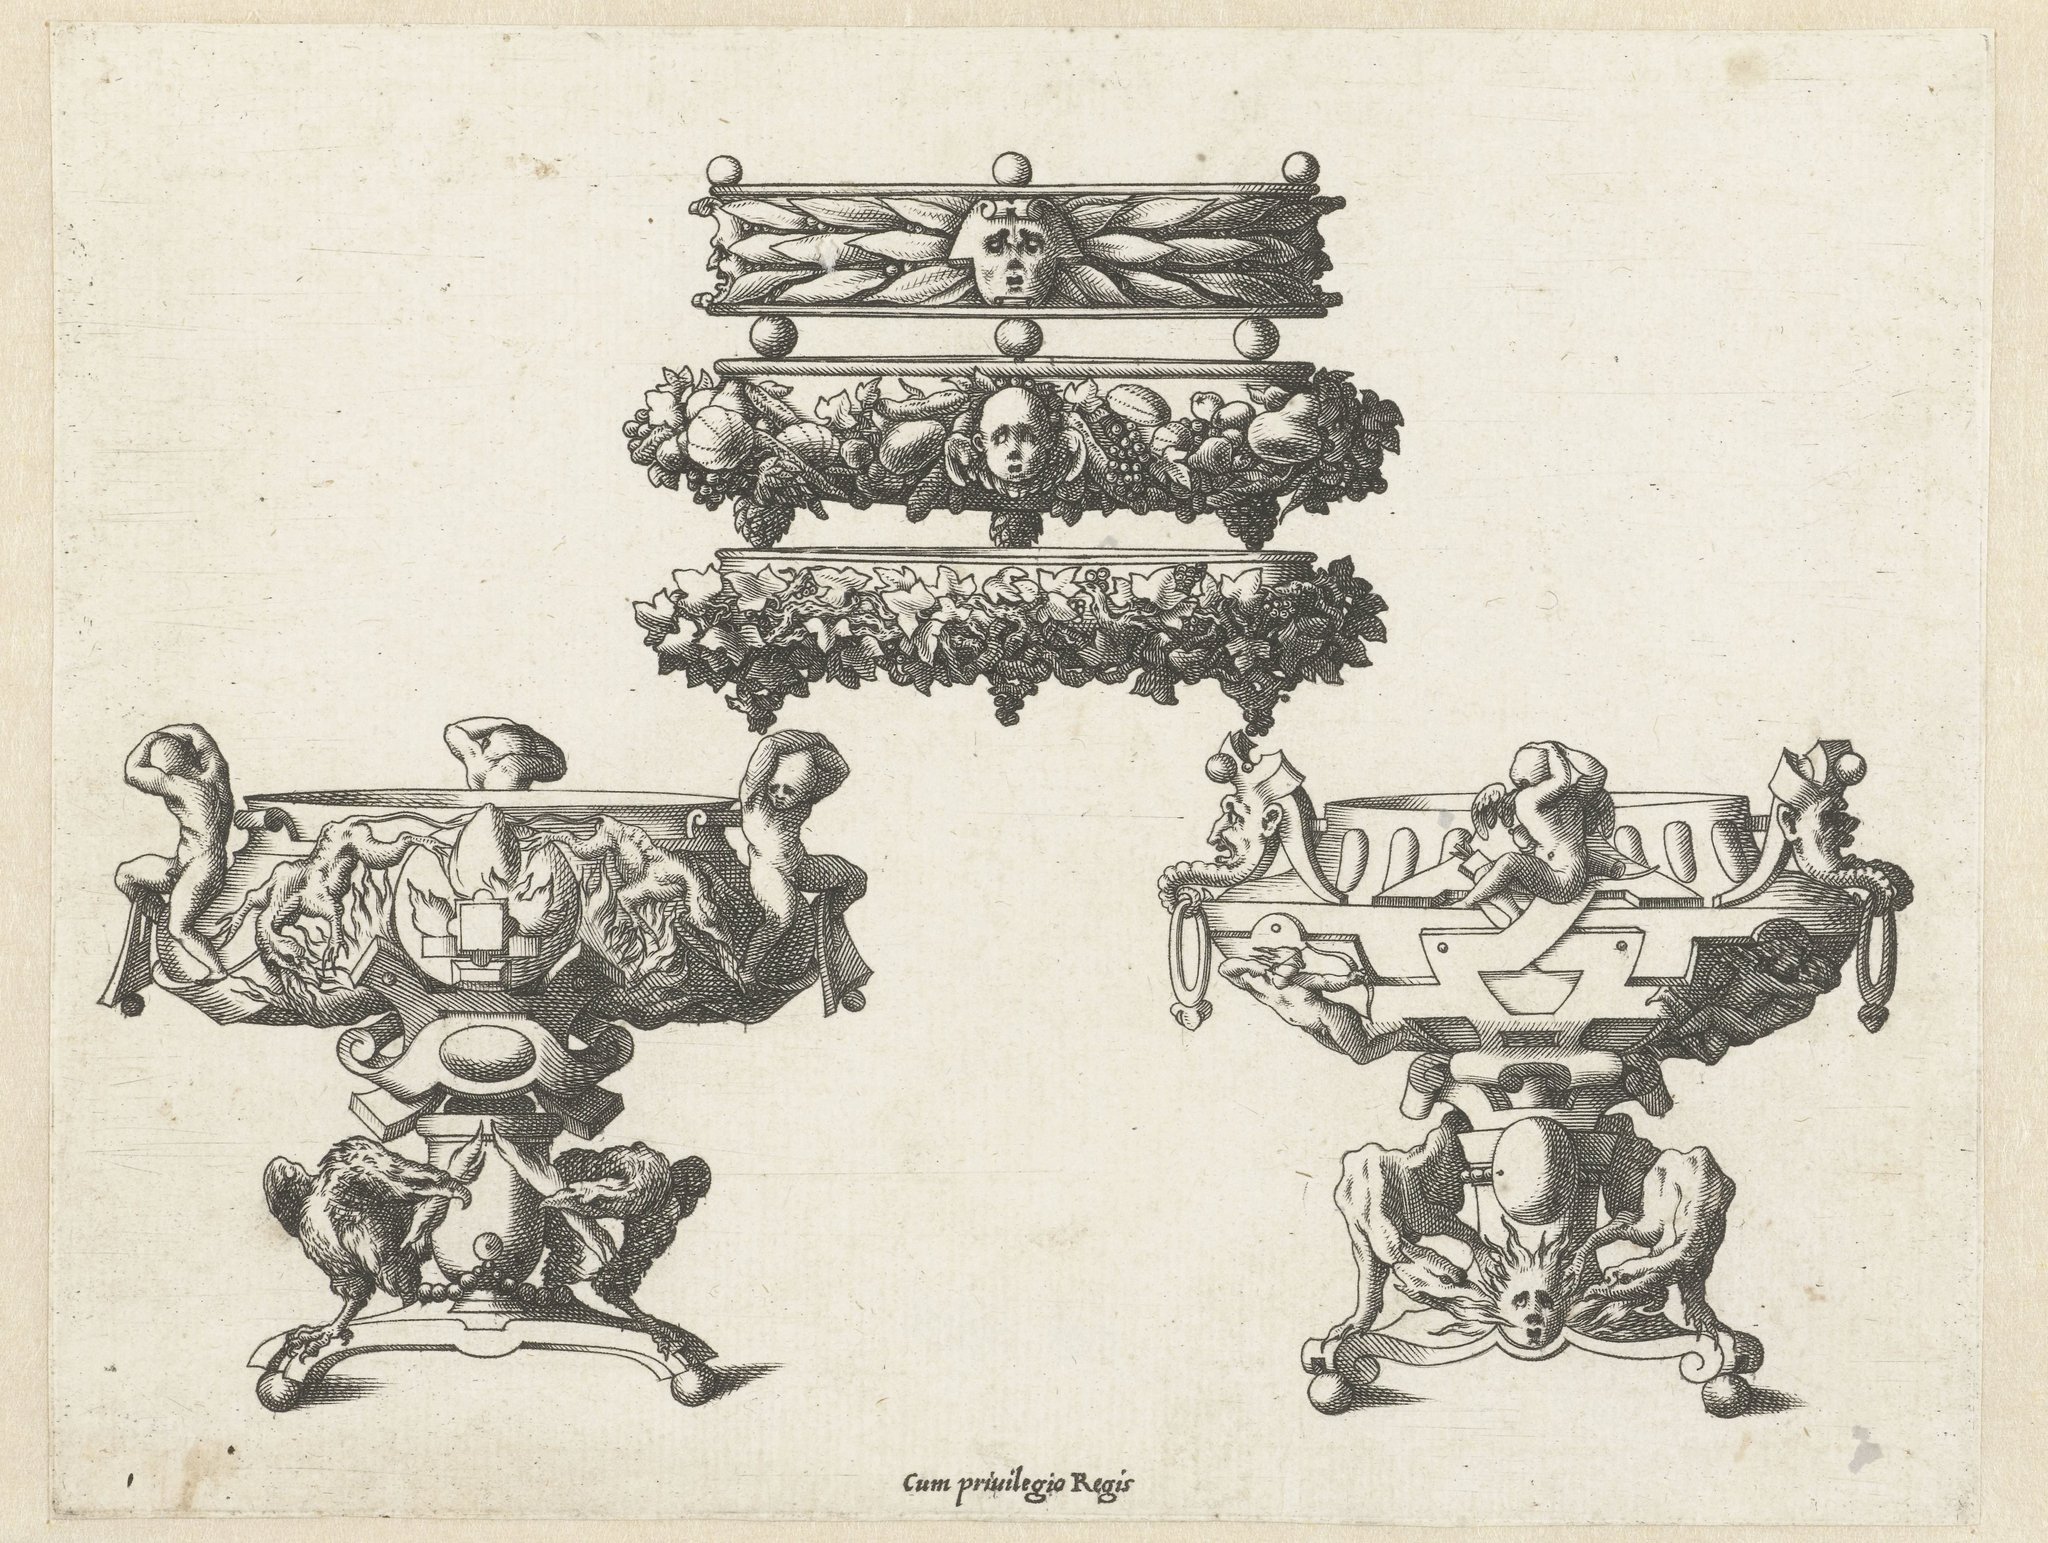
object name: ornament print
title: Tafelgerei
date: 1542-1580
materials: paper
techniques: engraving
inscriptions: collector's mark: Lugt 240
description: Drie plateaus, gedecoreerd met loofwerk, guirlandes en mascarons. Linksonder en rechtsonder een zoutvat gedecoreerd met rolwerk, kindertjes en putti. Op de voet van het linker vaatje zitten twee adelaars, op de voet van het rechter twee vuurspuwende draken.